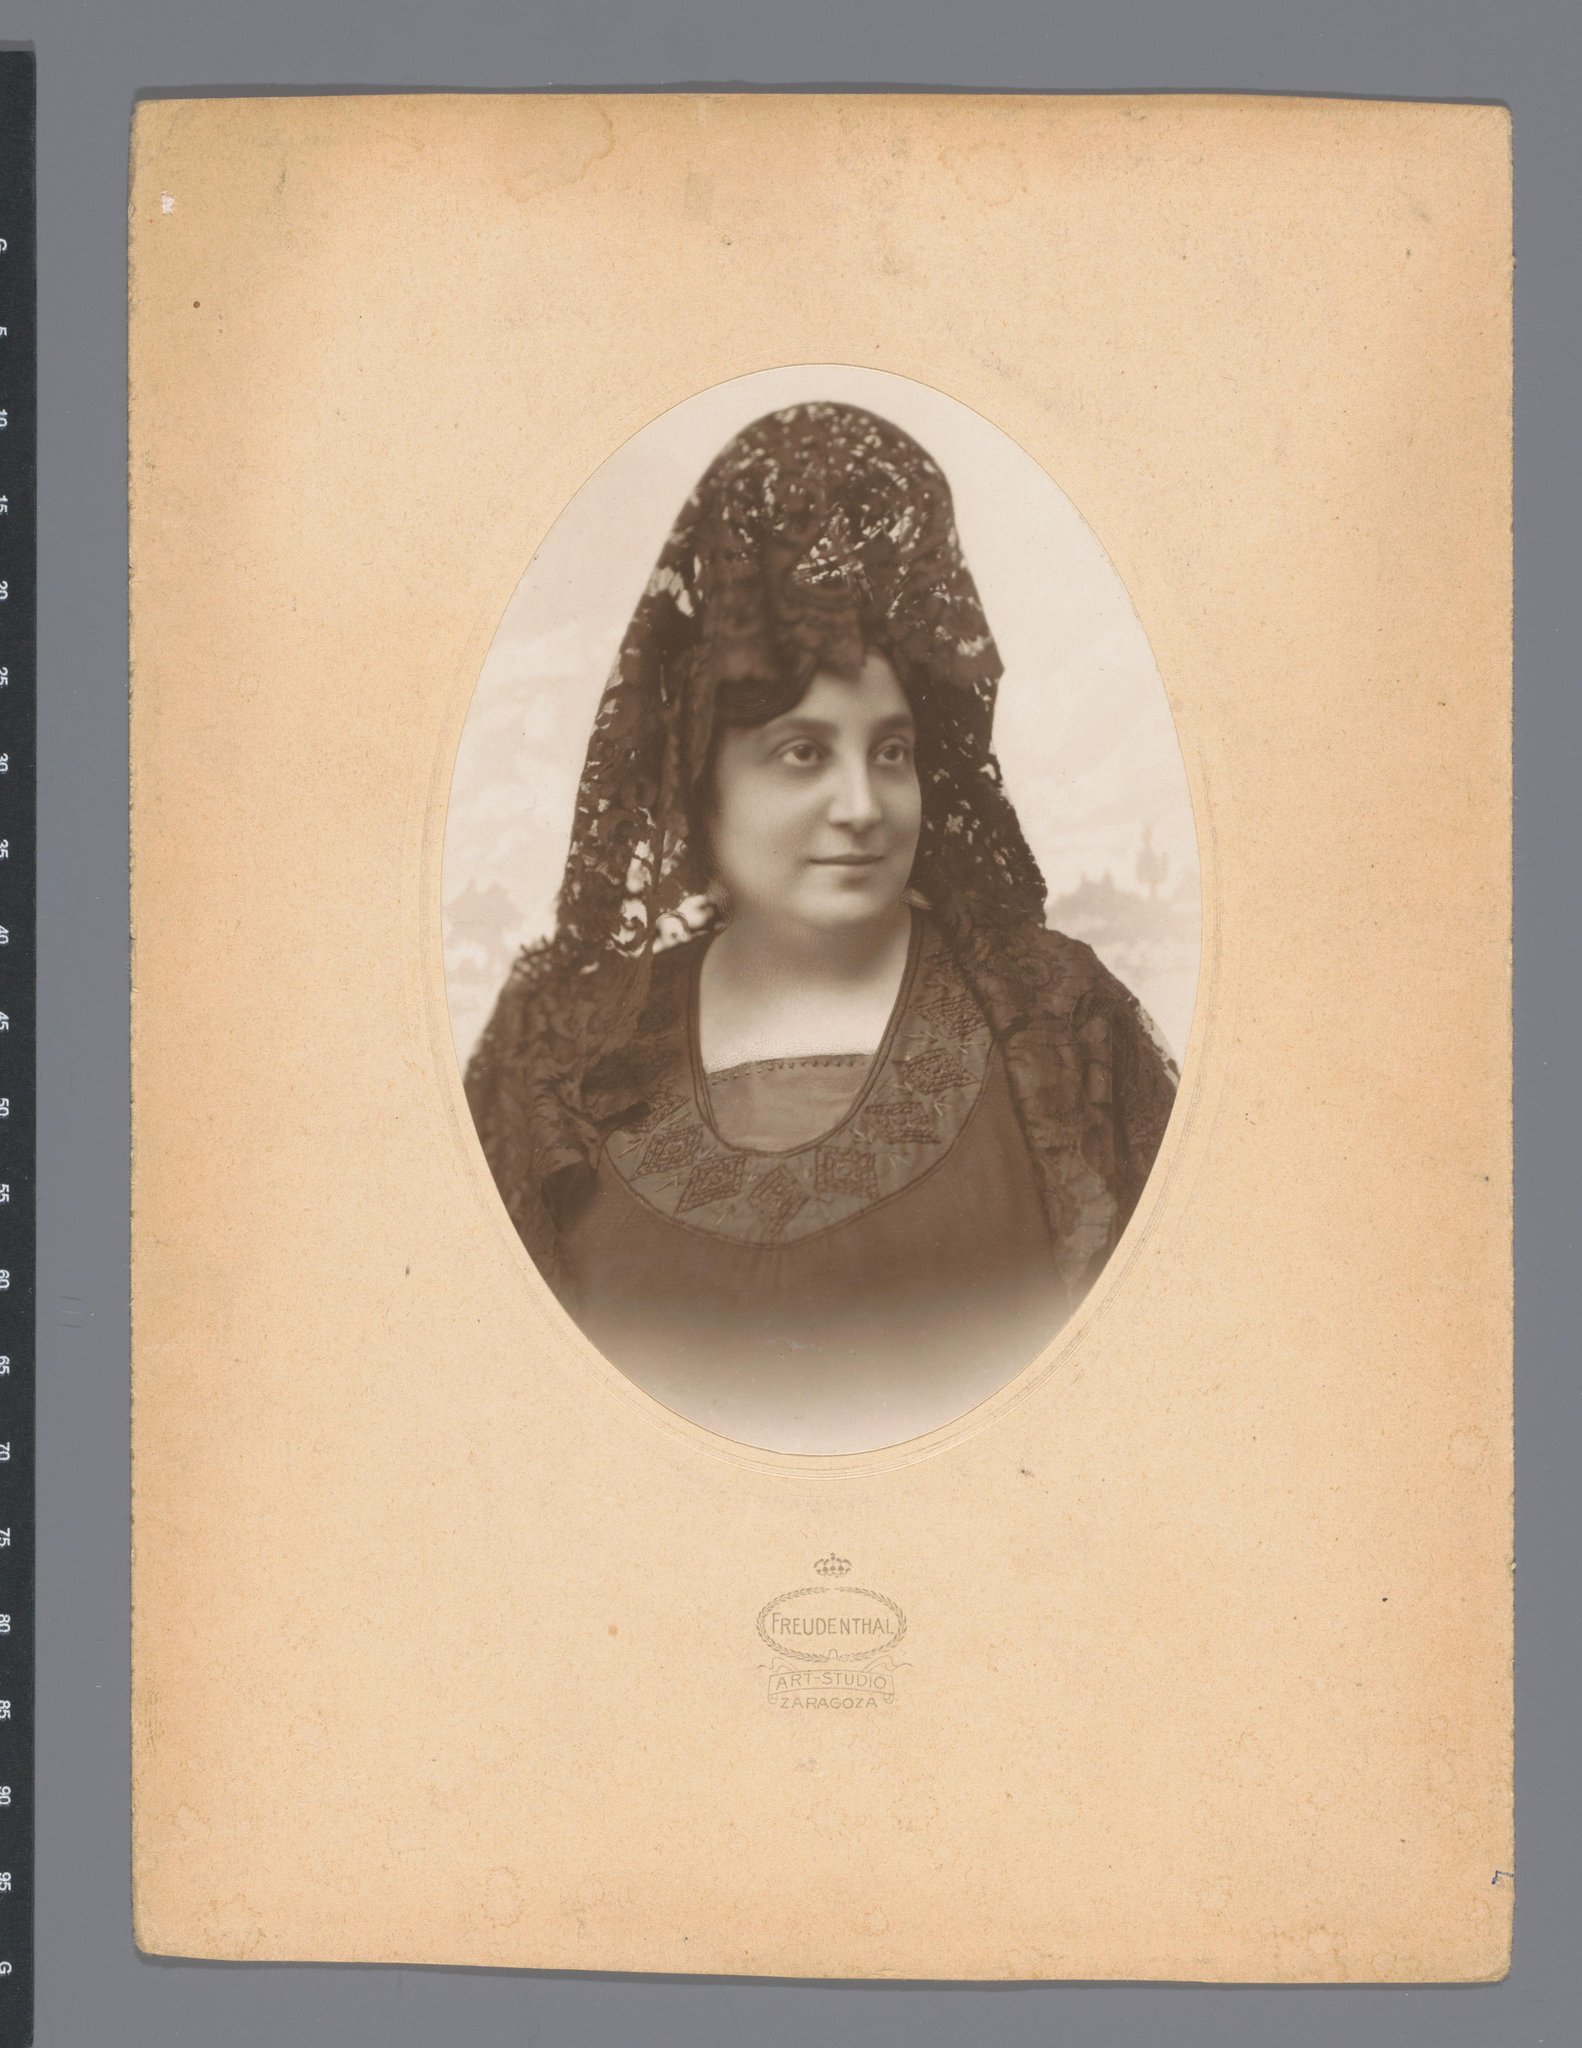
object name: photograph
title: Portret van een onbekende Spaanse vrouw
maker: gustavo freudenthal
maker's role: fotograaf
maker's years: 1869-1948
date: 1906-1930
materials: paper, cardboard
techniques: gelatin silver print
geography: zaragoza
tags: adult woman, anonymous historical person portrayed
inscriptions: inscription: ‘[onleesbaar]’